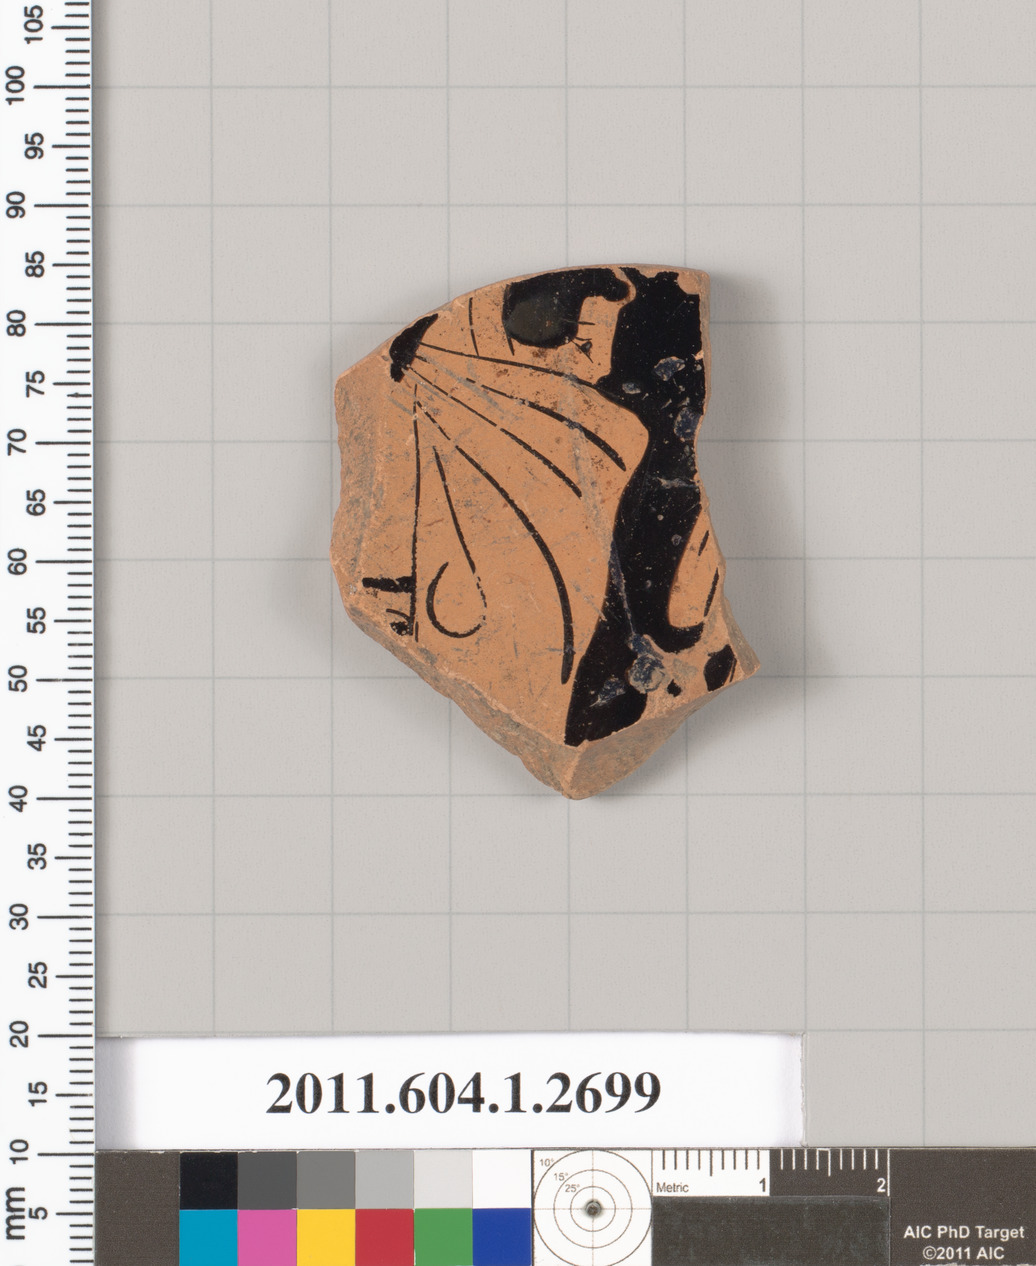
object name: kylix fragment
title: Terracotta fragment of a kylix (drinking cup)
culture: greek, attic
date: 451-475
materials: terracotta